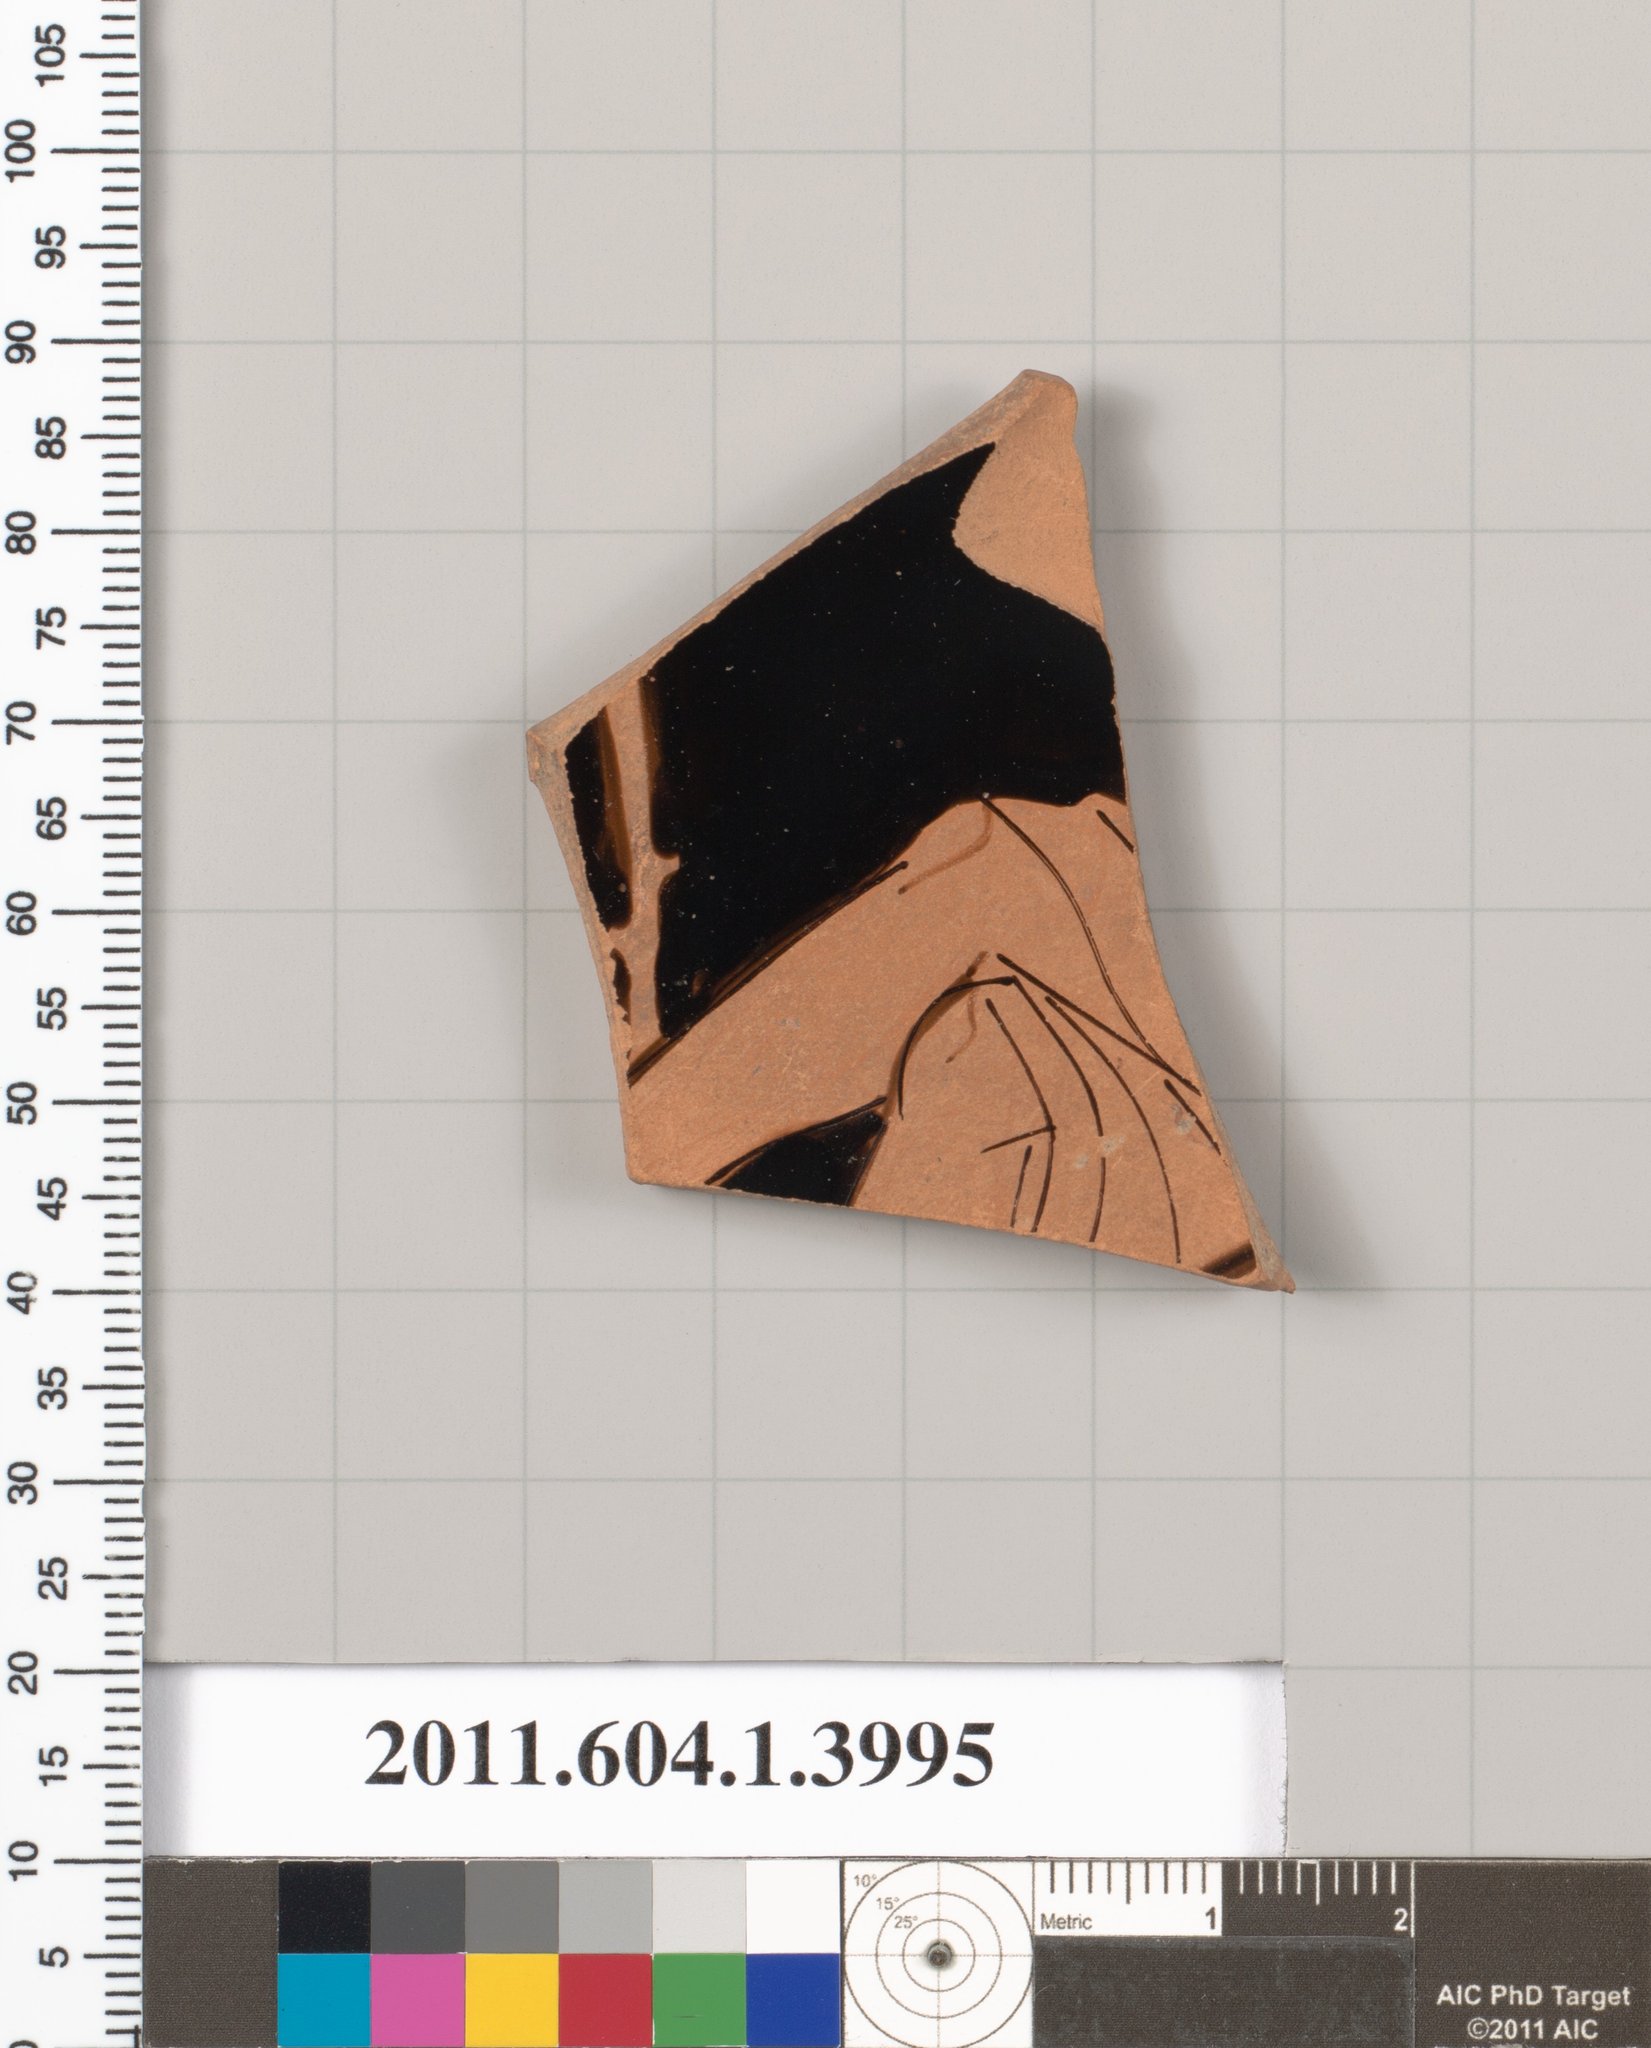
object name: kylix fragment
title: Terracotta fragment of a kylix (drinking cup)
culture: greek, attic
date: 475-451 BCE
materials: terracotta